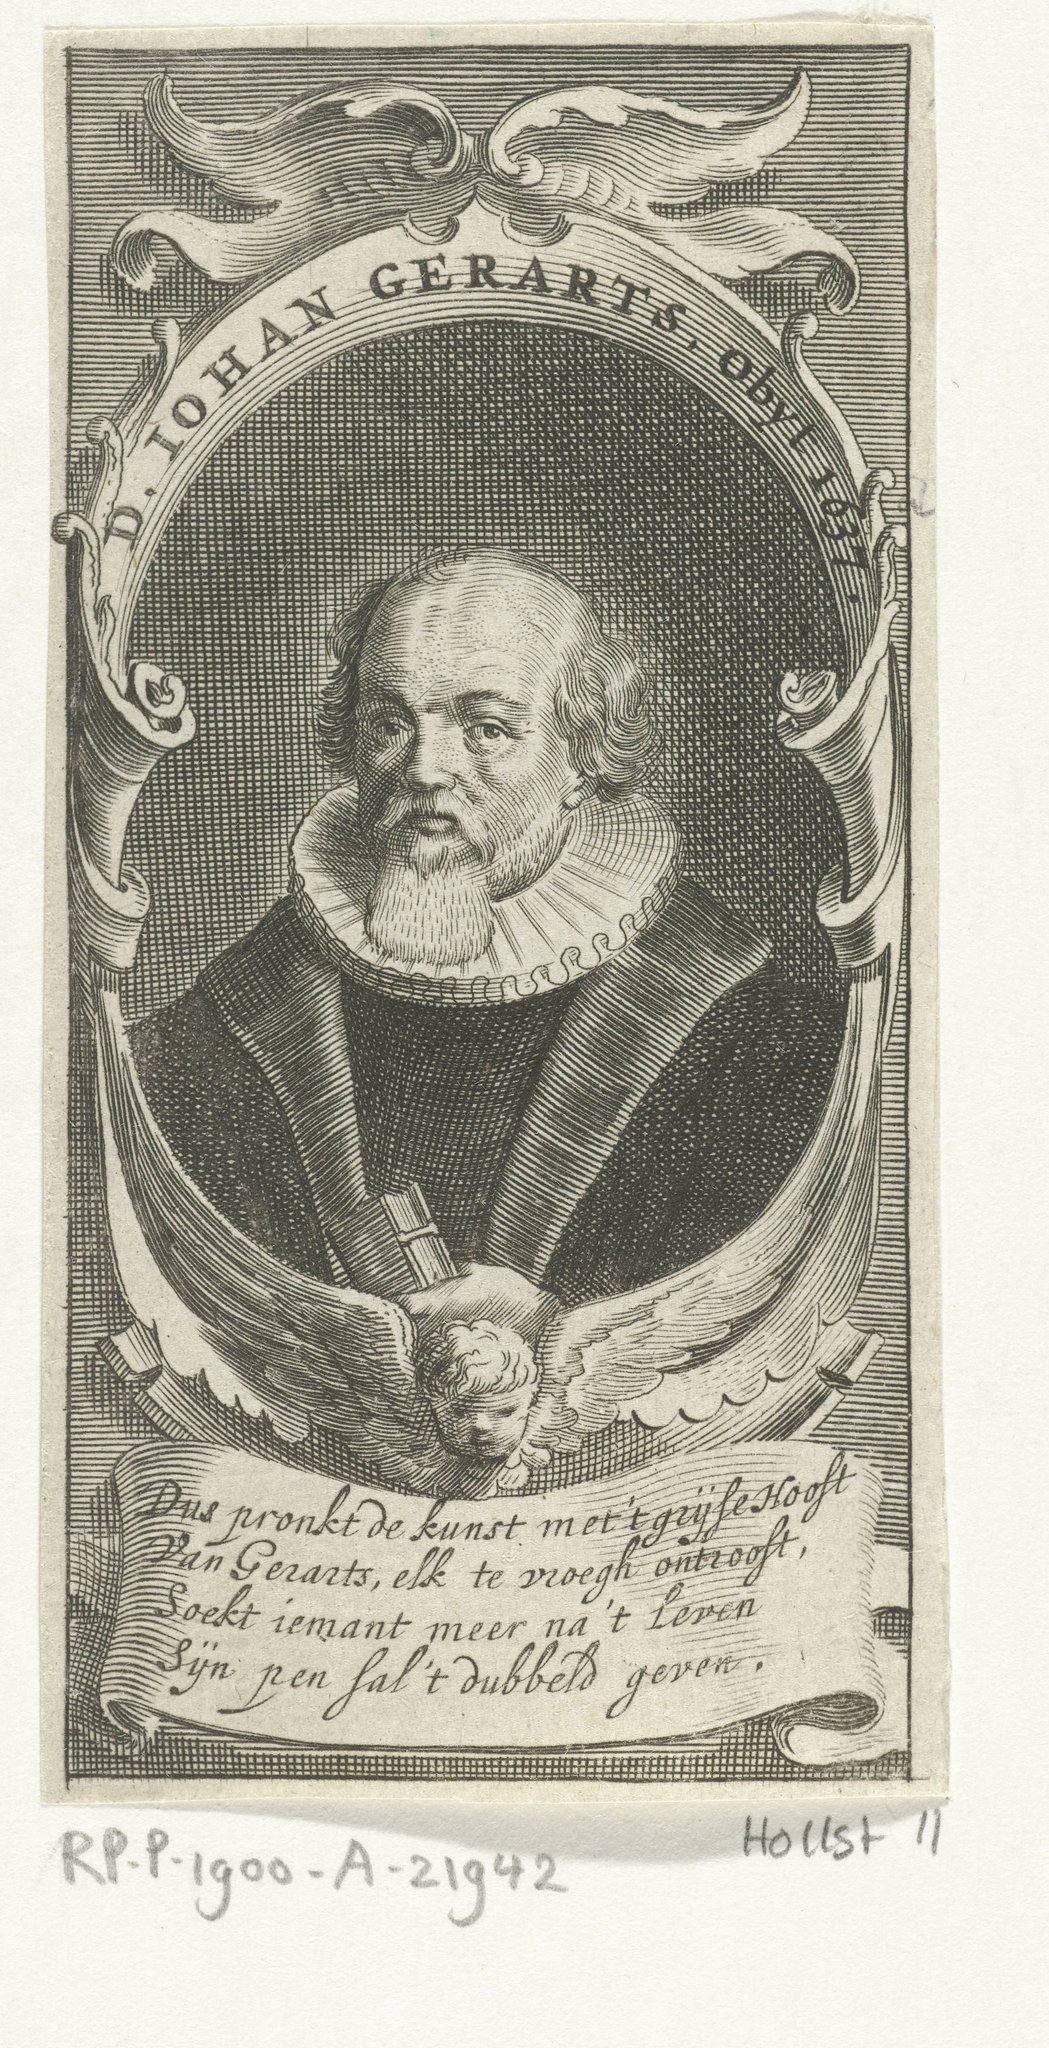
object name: print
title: Portret van Johannes Gerarts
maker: pieter holsteyn (ii)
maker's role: draughtsman, print maker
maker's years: 1614-1673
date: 1637-1673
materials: paper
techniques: engraving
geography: northern netherlands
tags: priest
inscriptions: collector's mark: Lugt 2228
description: Buste van Johannes Gerarts in een gedecoreerd cartouche met onderaan een engelenkopje. Onderaan een banderol met vier regels in het Nederlands.